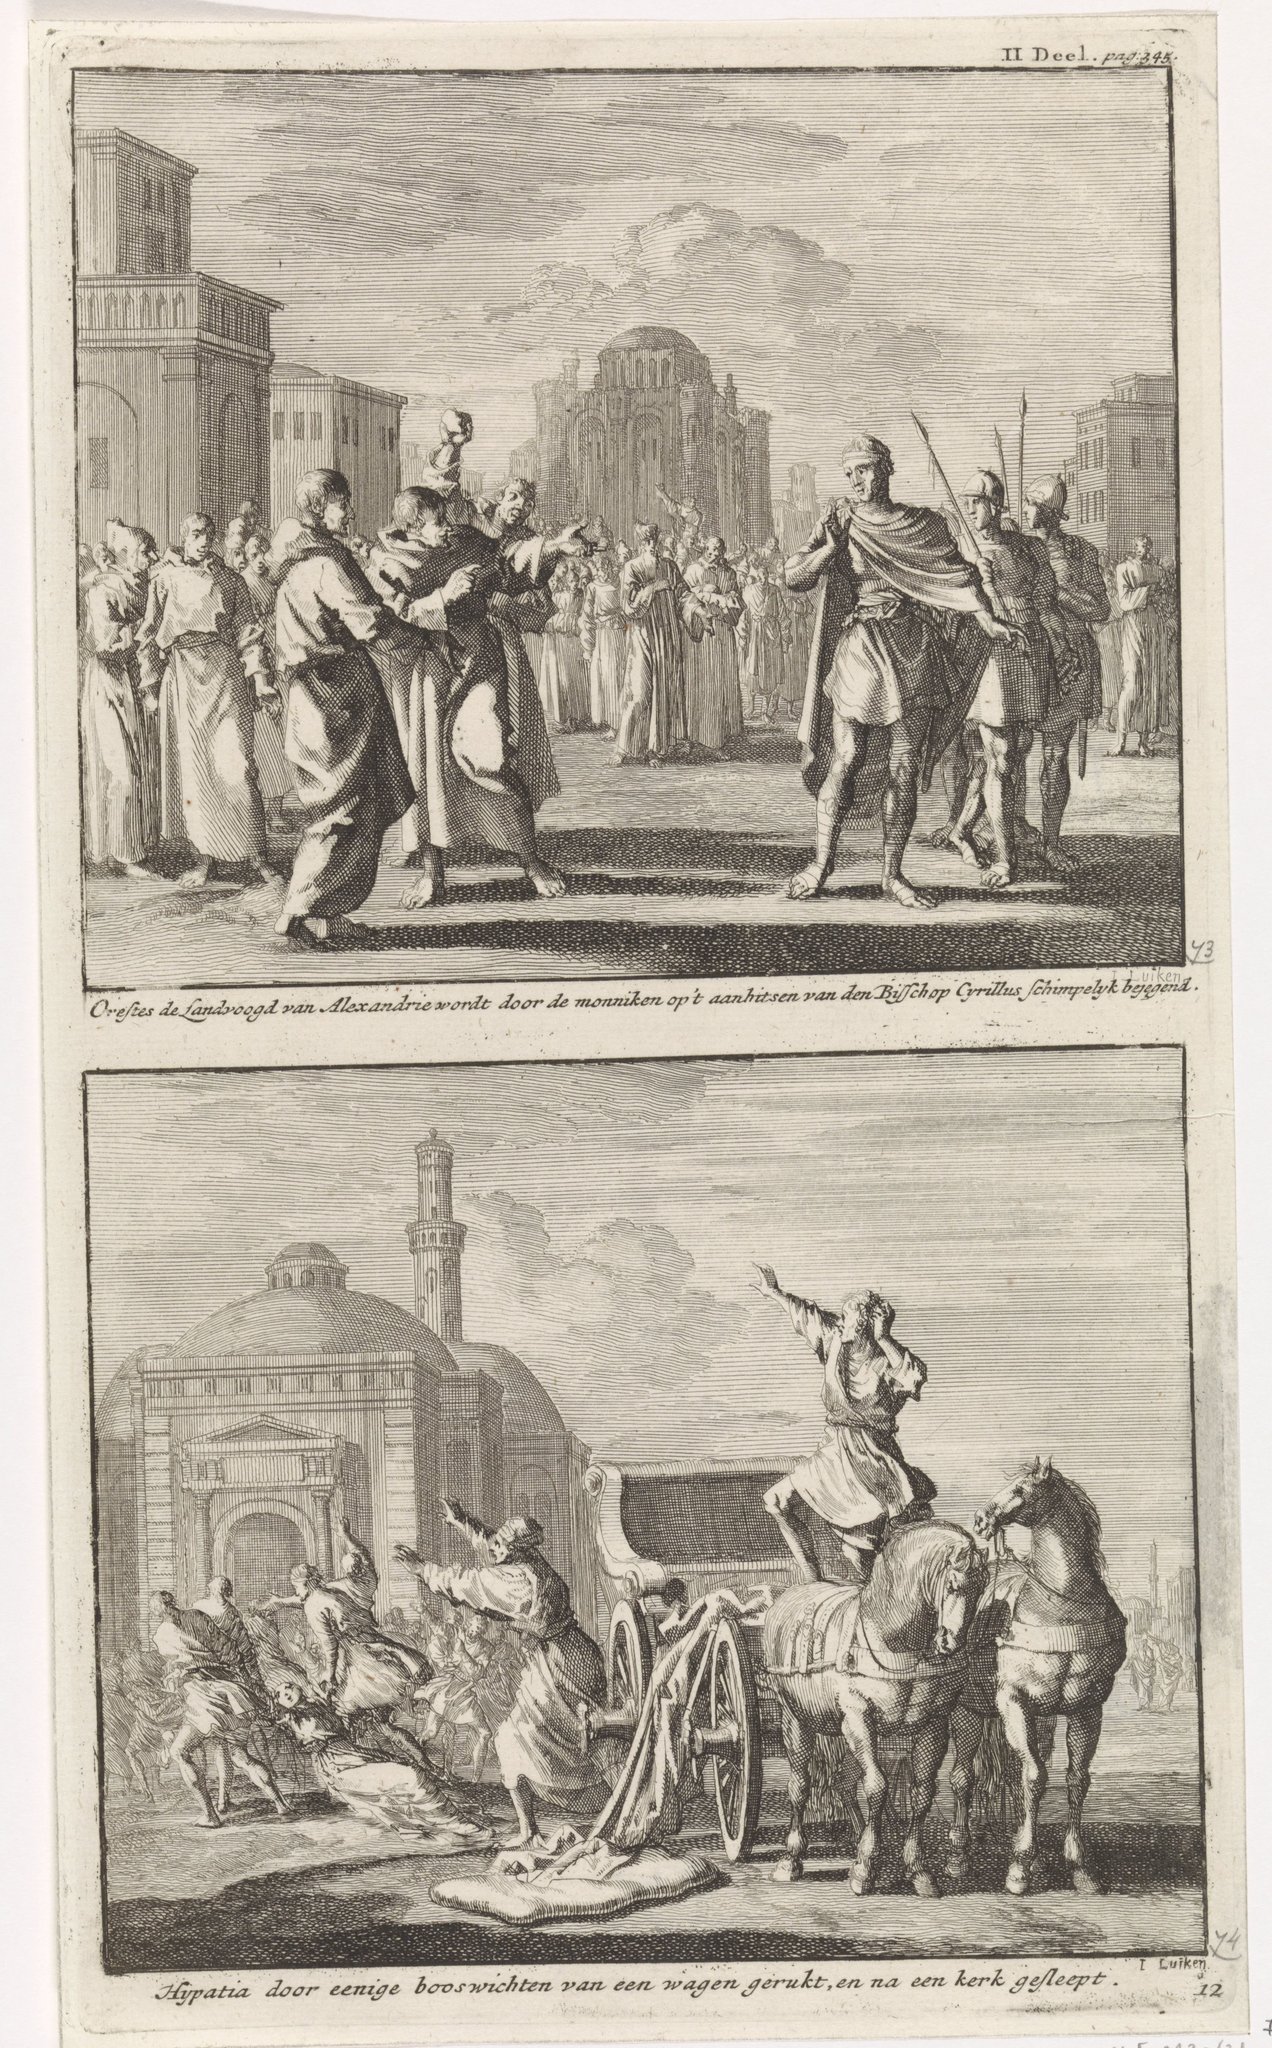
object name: print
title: Prefect Orestes wordt door monniken bespot en Hypatia die door Christenen van haar koets wordt getrokken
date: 1701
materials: paper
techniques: etching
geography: amsterdam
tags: violent death by stoning - ee - death not certain; wounded person, the early christian churches, e.g. armenians, copts, syrians, monk(s), friar(s), mocking, insulting; teasing, male saints (with name), abducting, four-wheeled vehicle drawn by two animals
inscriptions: collector's mark: Lugt 2228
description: Twee voorstellingen op een plaat. Boven: op de voorgrond rechts Orestes, de prefect van Alexandrië. Hij wordt door enkele monniken bespot. Een van de monniken gooit een steen naar hem. Op de achtergrond patriarch Cyrillus van Alexandrië, die preekt tegen Orestes. Onder: de filosofe Hypatia wordt door Christenen van haar koets getrokken en naar een kerk gesleurd, om daar te worden vermoord.